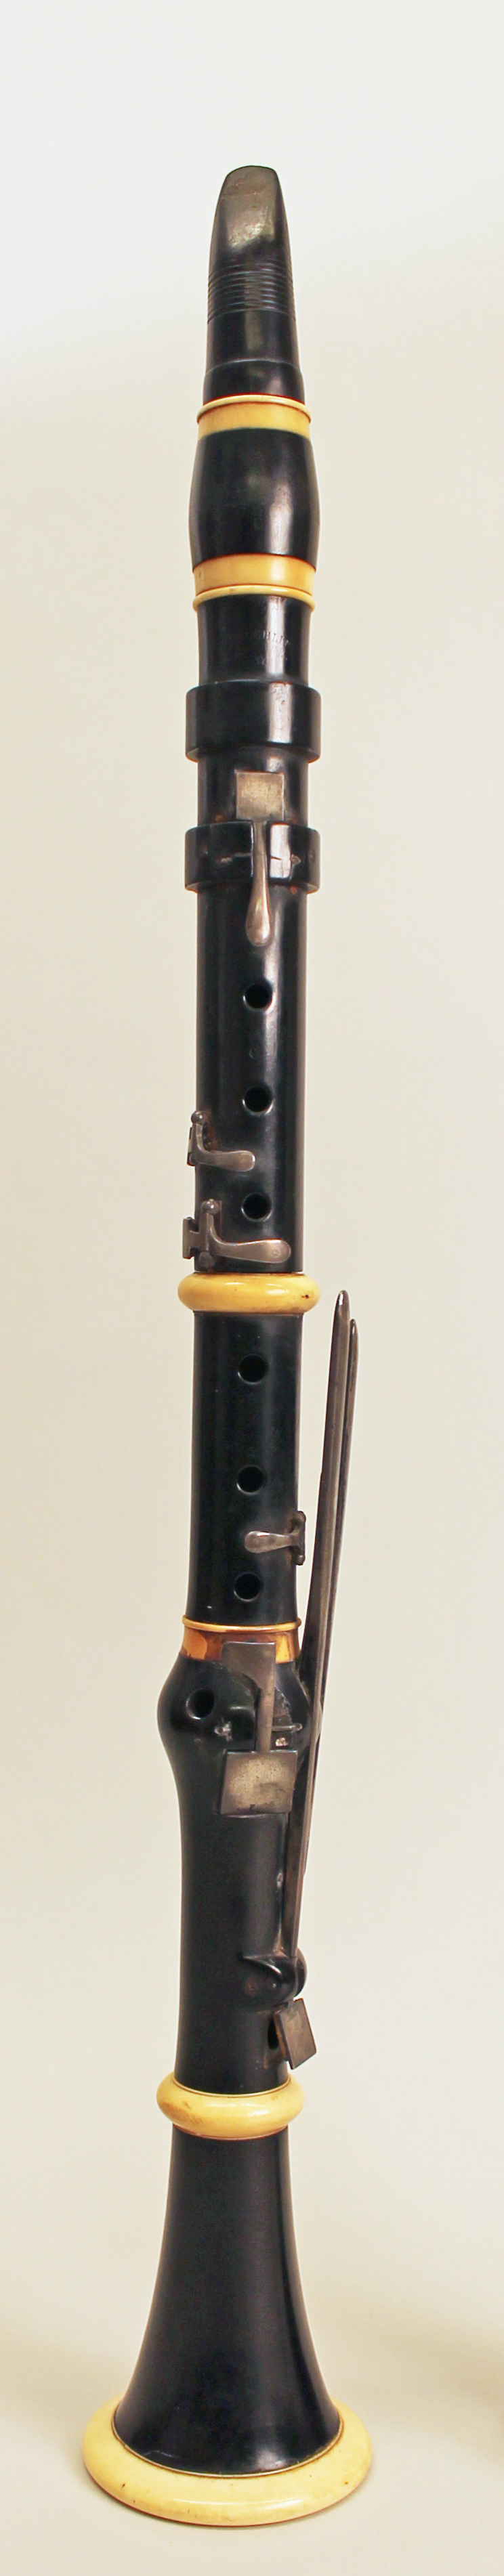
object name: clarinet in c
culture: swiss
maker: josef karl anton "charles" felchlin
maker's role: maker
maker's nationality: swiss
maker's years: 1800-1855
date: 1836-1855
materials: ivory, silver, wood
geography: switzerland